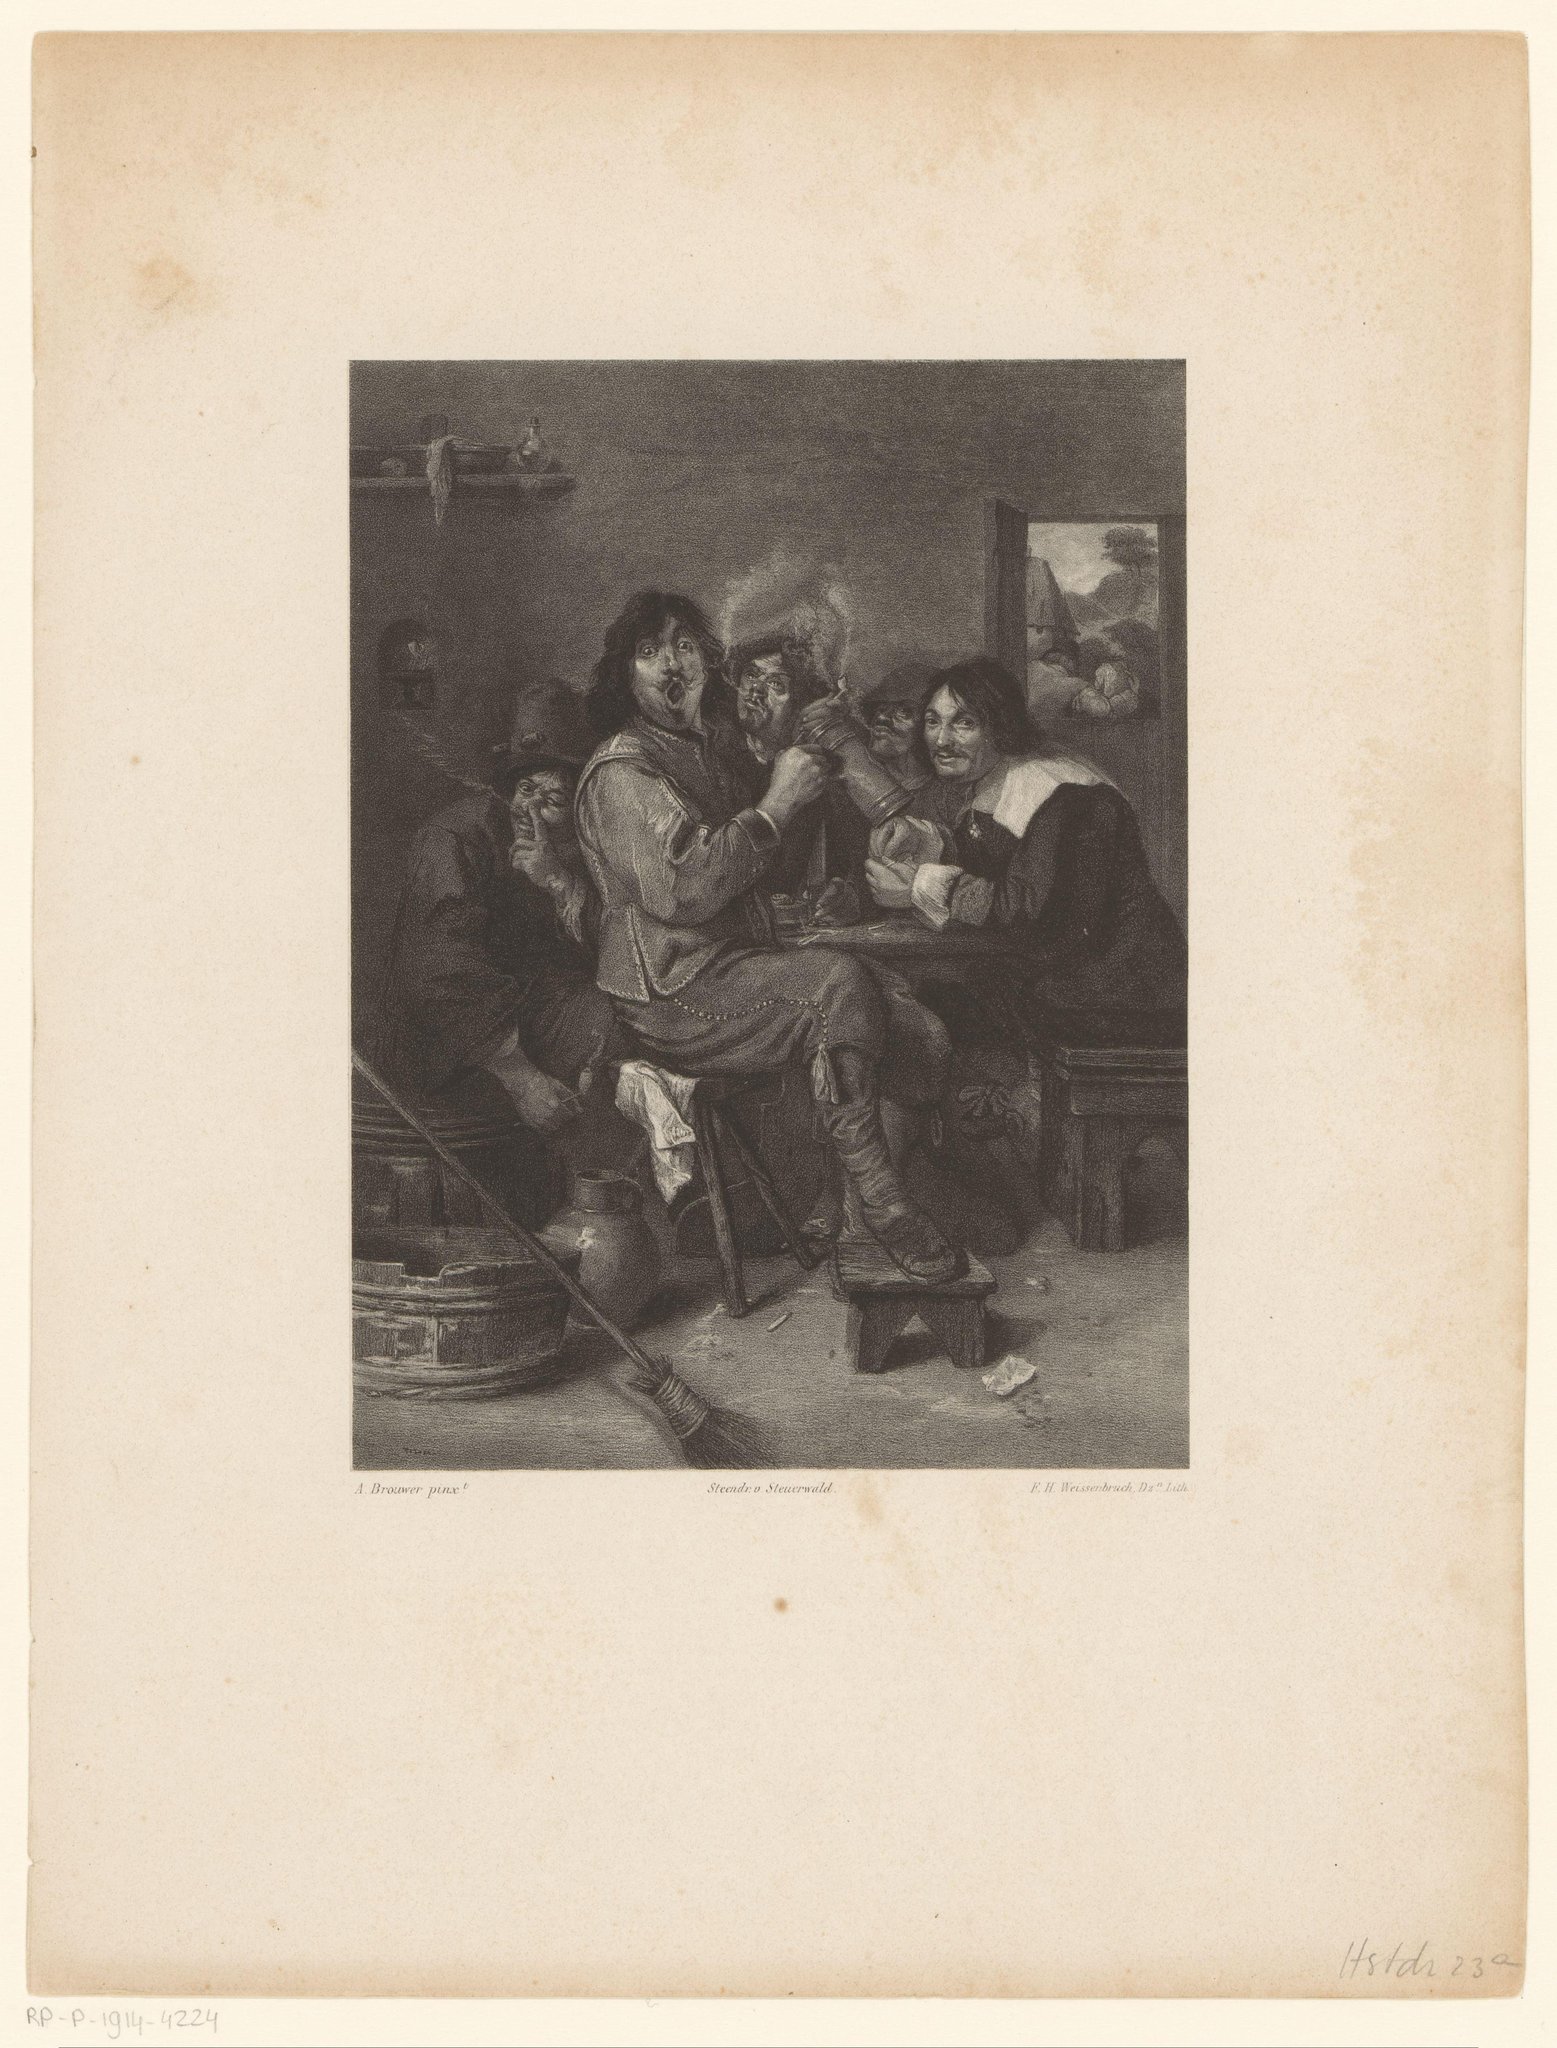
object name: print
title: Herberginterieur met rokers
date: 1838-1863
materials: paper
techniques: lithograph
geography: the hague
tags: pipe ~ tobacco, jar, jug (used as drinking-vessel)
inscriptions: collector's mark: Lugt 2228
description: In een herberg zitten vijf mannen rond een tafel, die pijp roken. De man in het midden blaast rook uit en houdt een kruik in zijn hand.